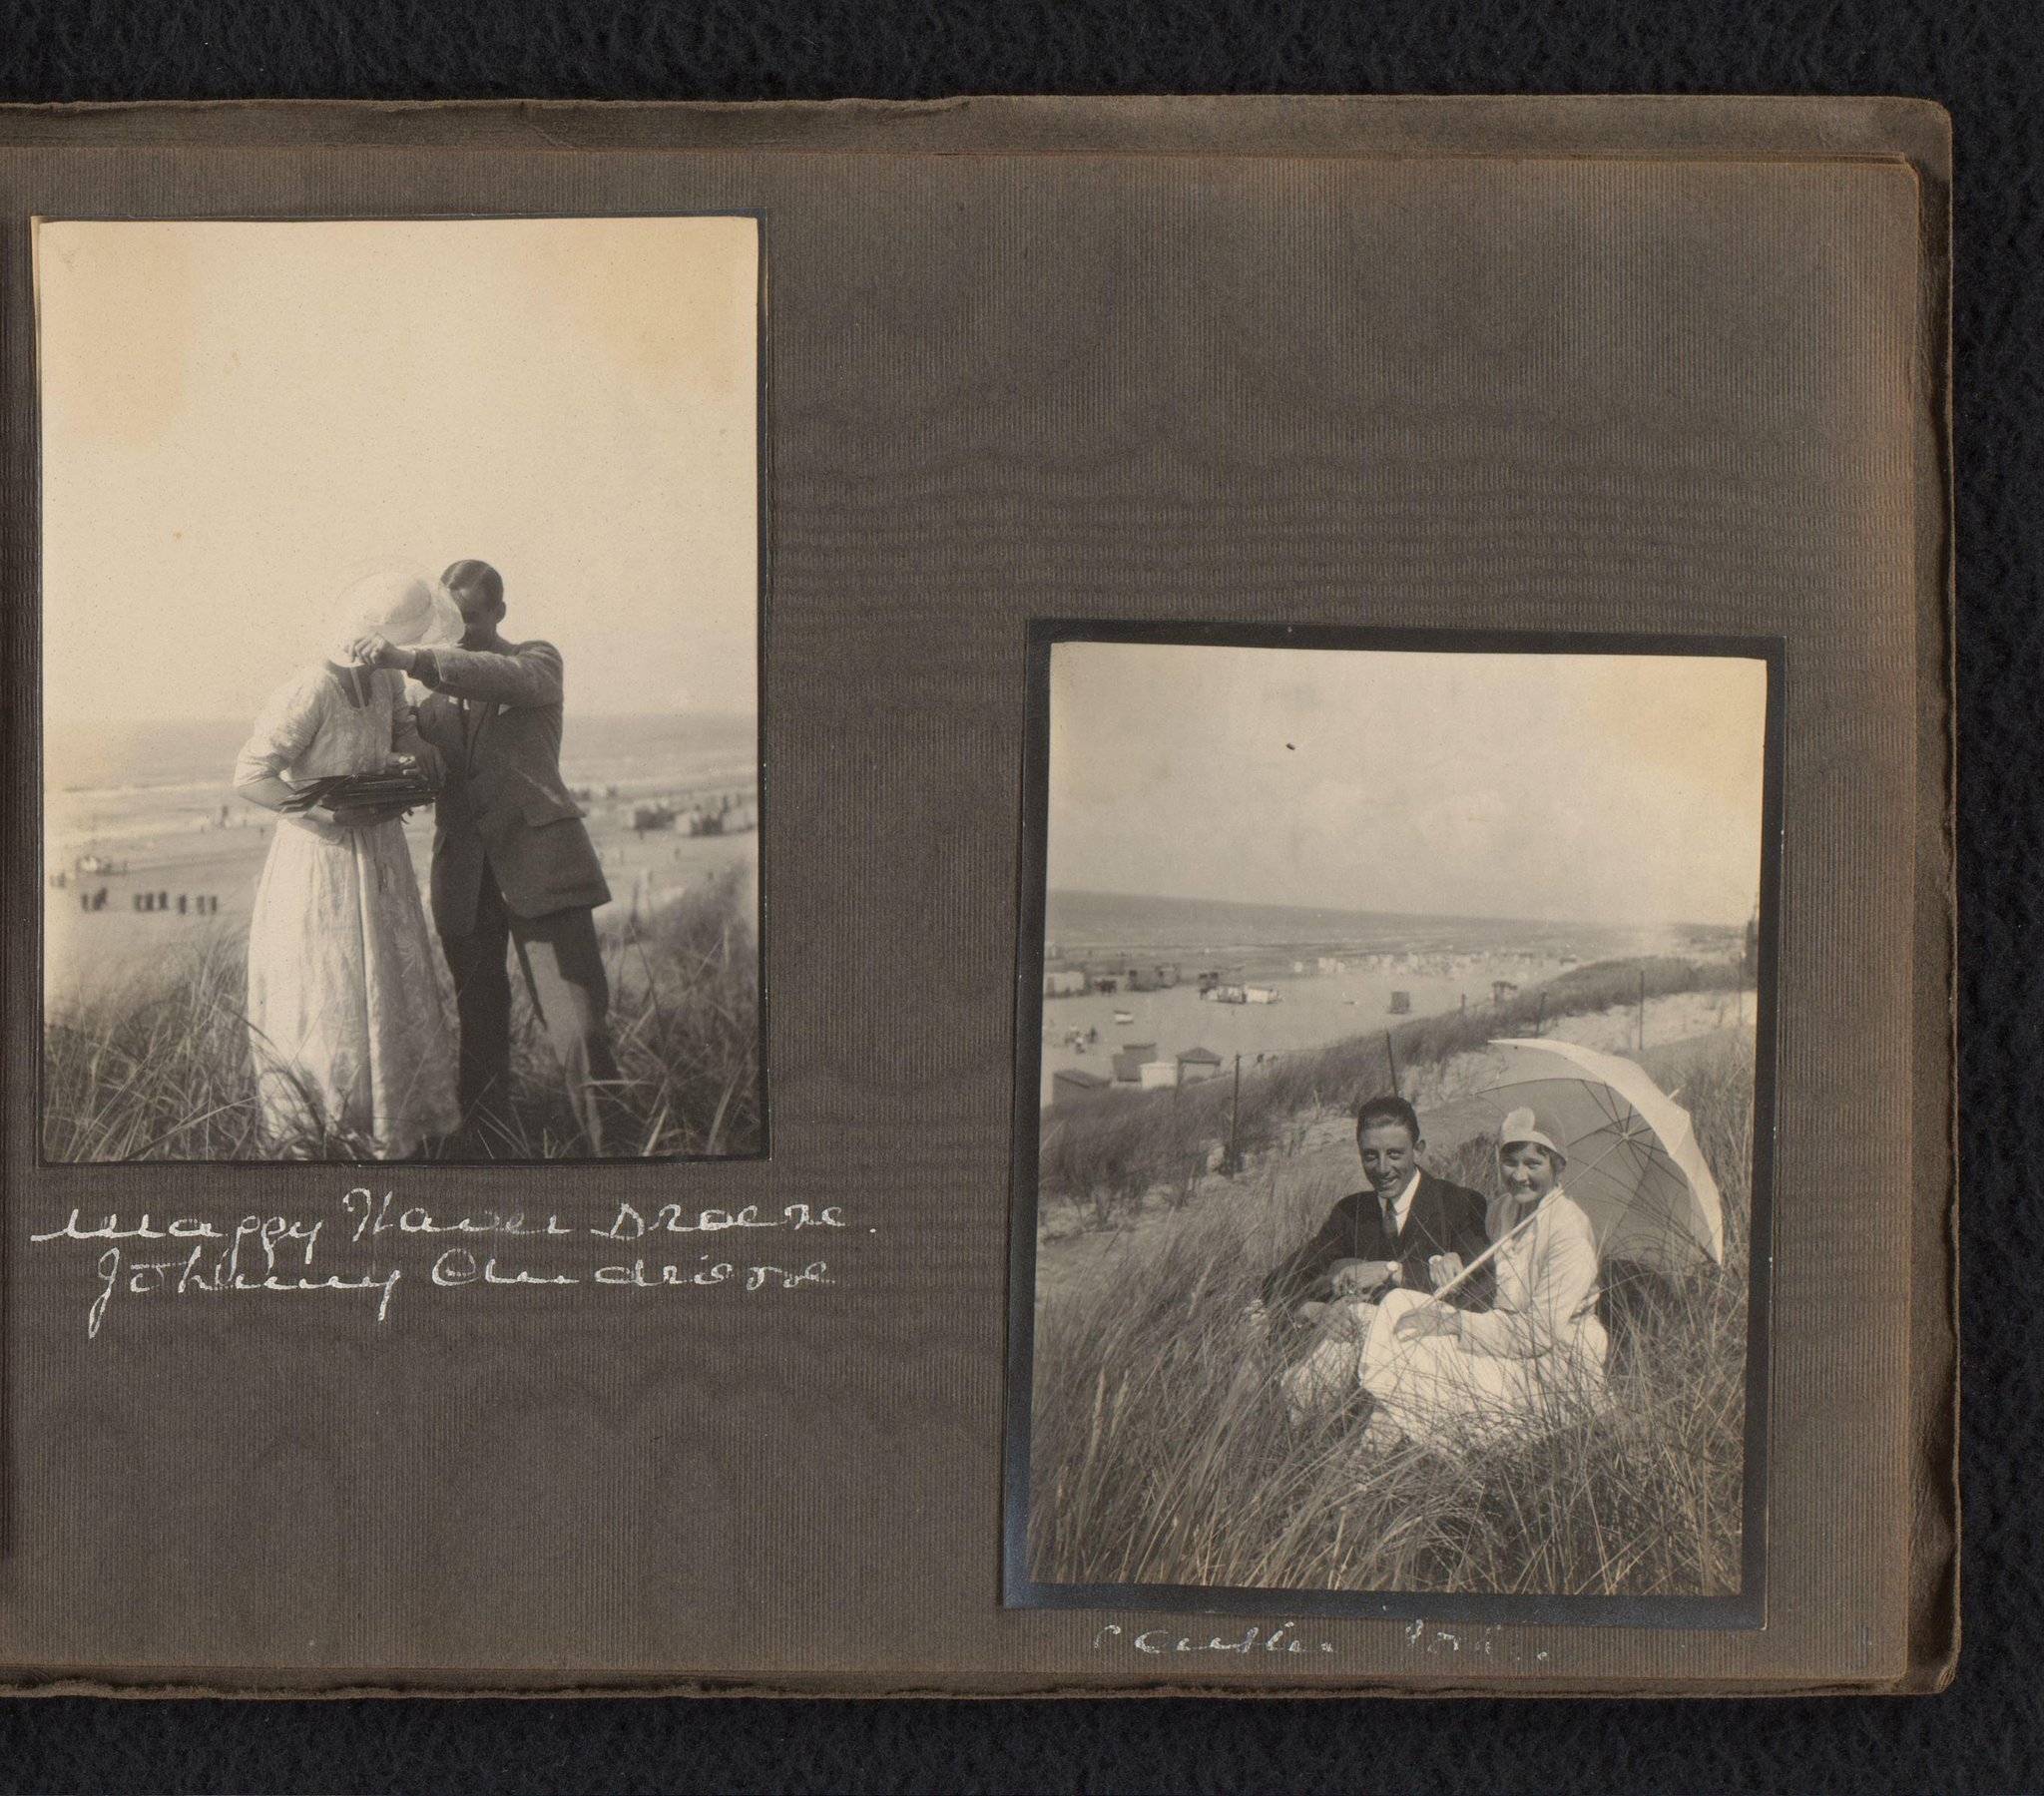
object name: photograph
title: Twee foto's van twee stellen in de duinen van Noordwijk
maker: Anonymous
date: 1908-1917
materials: paper, cardboard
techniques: gelatin silver print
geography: noordwijk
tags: recreation in the dunes, historical persons - bb - woman, historical persons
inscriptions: caption: ‘[...] Driesse/ Johnny Andriesse/ [...]’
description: Deze foto's maken deel uit van een album.